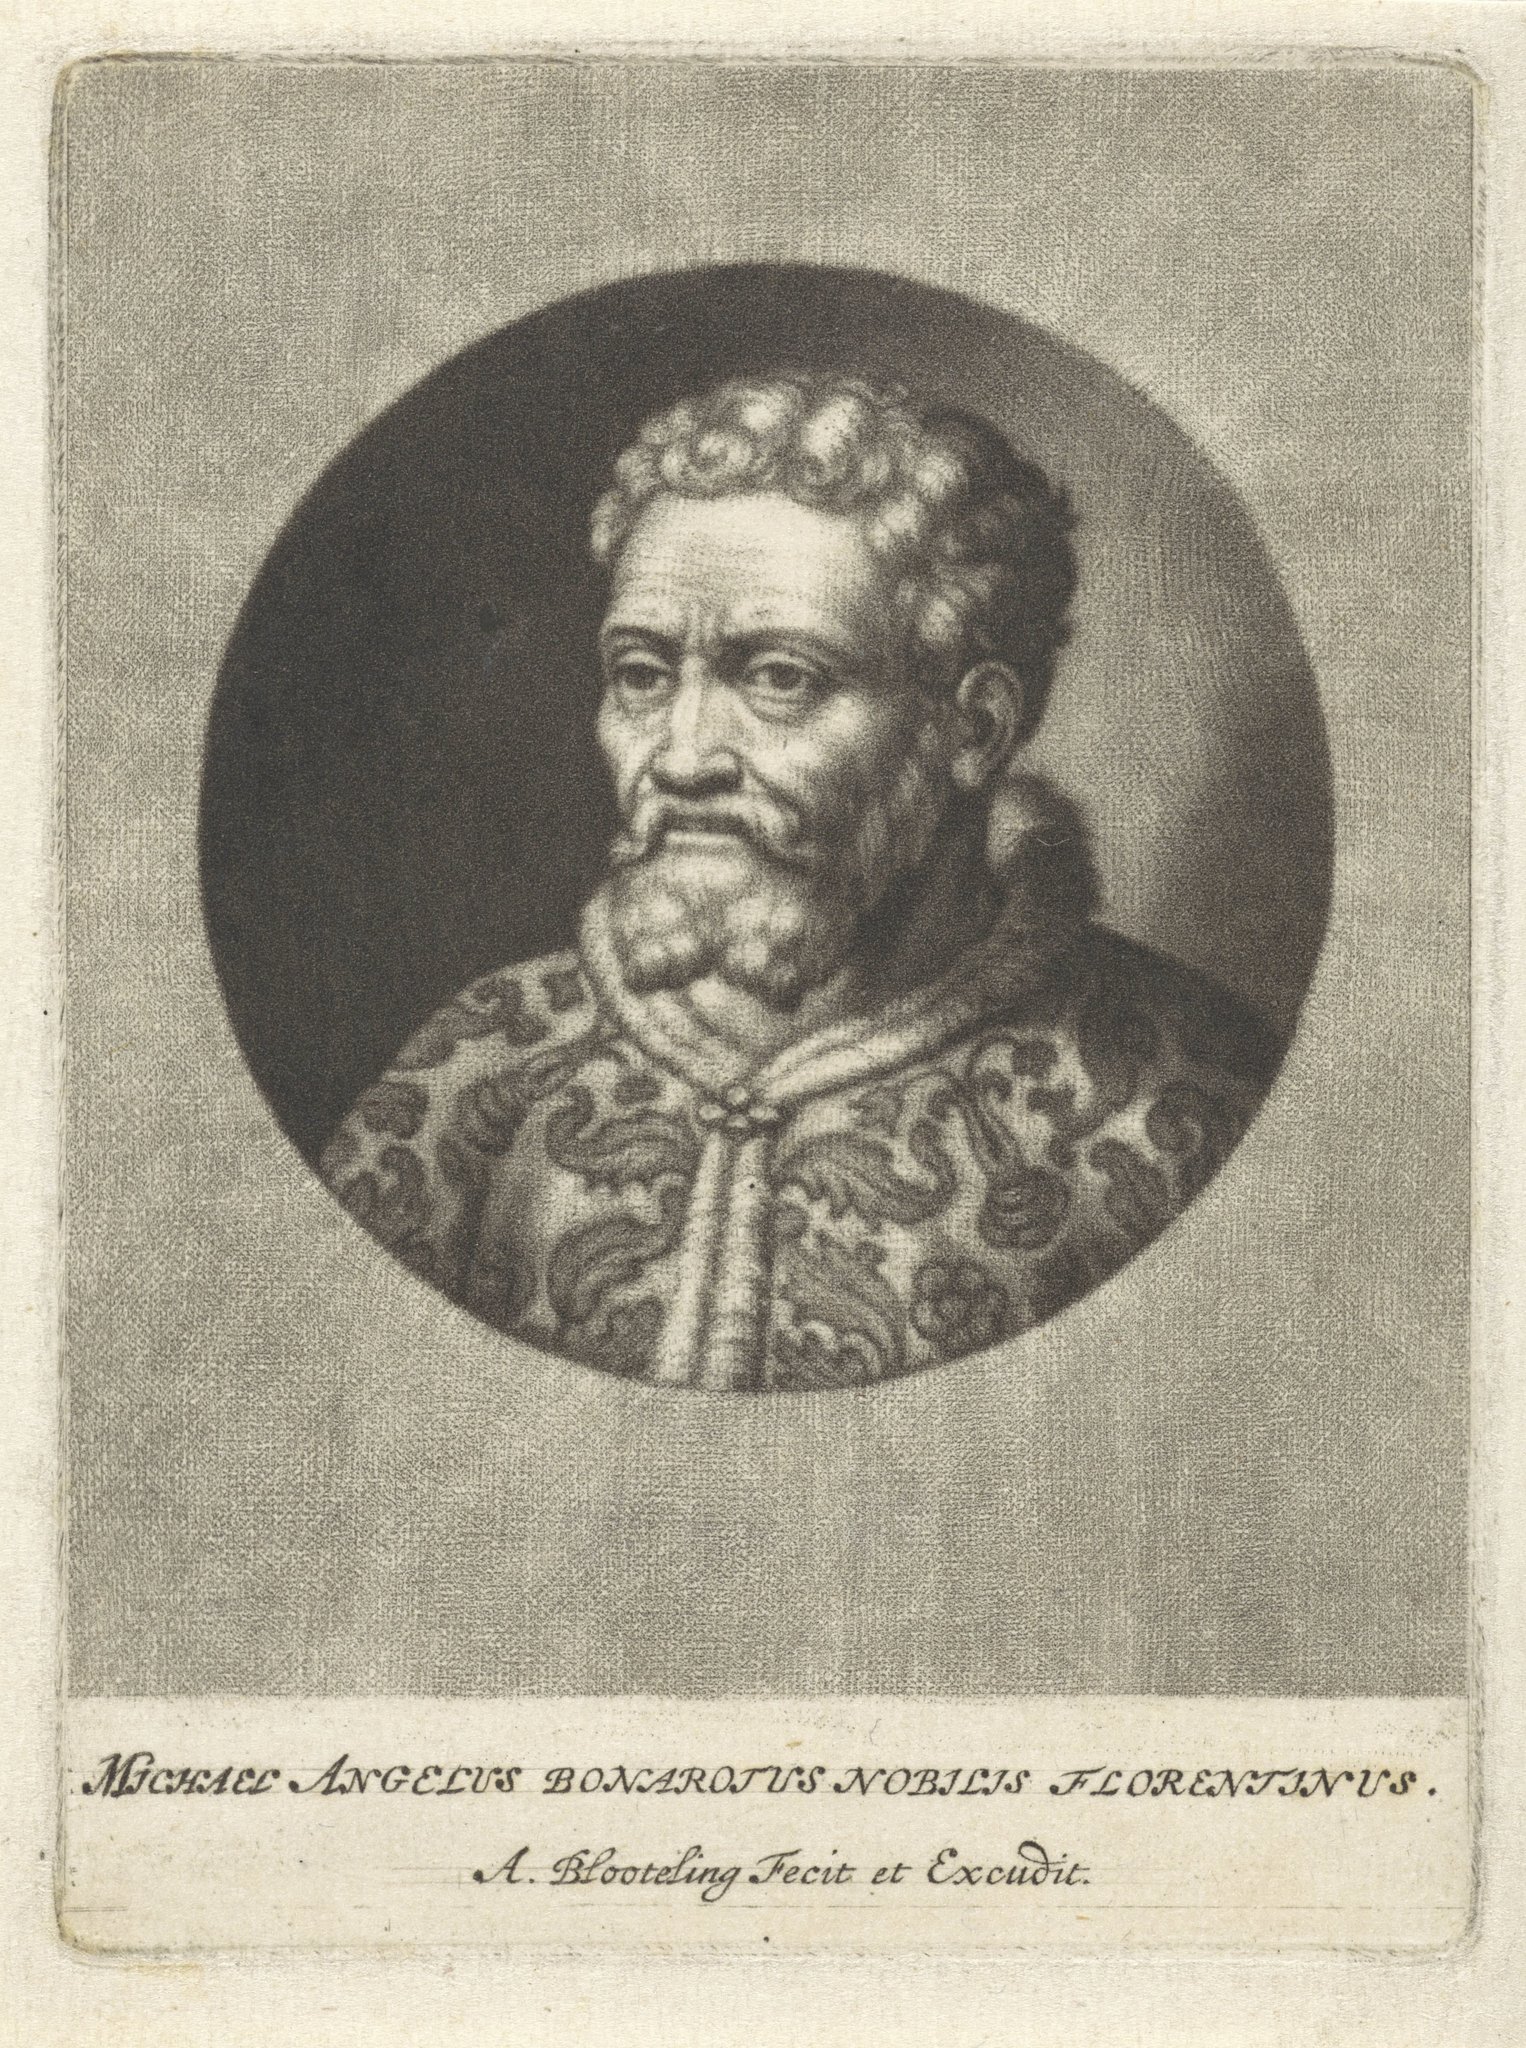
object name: print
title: Portret van Michelangelo Buonarroti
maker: abraham bloteling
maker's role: draughtsman, print maker, publisher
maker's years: 1640-1690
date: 1652-1690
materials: paper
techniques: engraving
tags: rome, draughtsman, sculptor, michelangelo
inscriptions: collector's mark: Lugt 2228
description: Portret van de Italiaanse kunstschilder, beeldhouwer, architect en dichter Michelangelo di Lodovico Buonarroti Simoni.